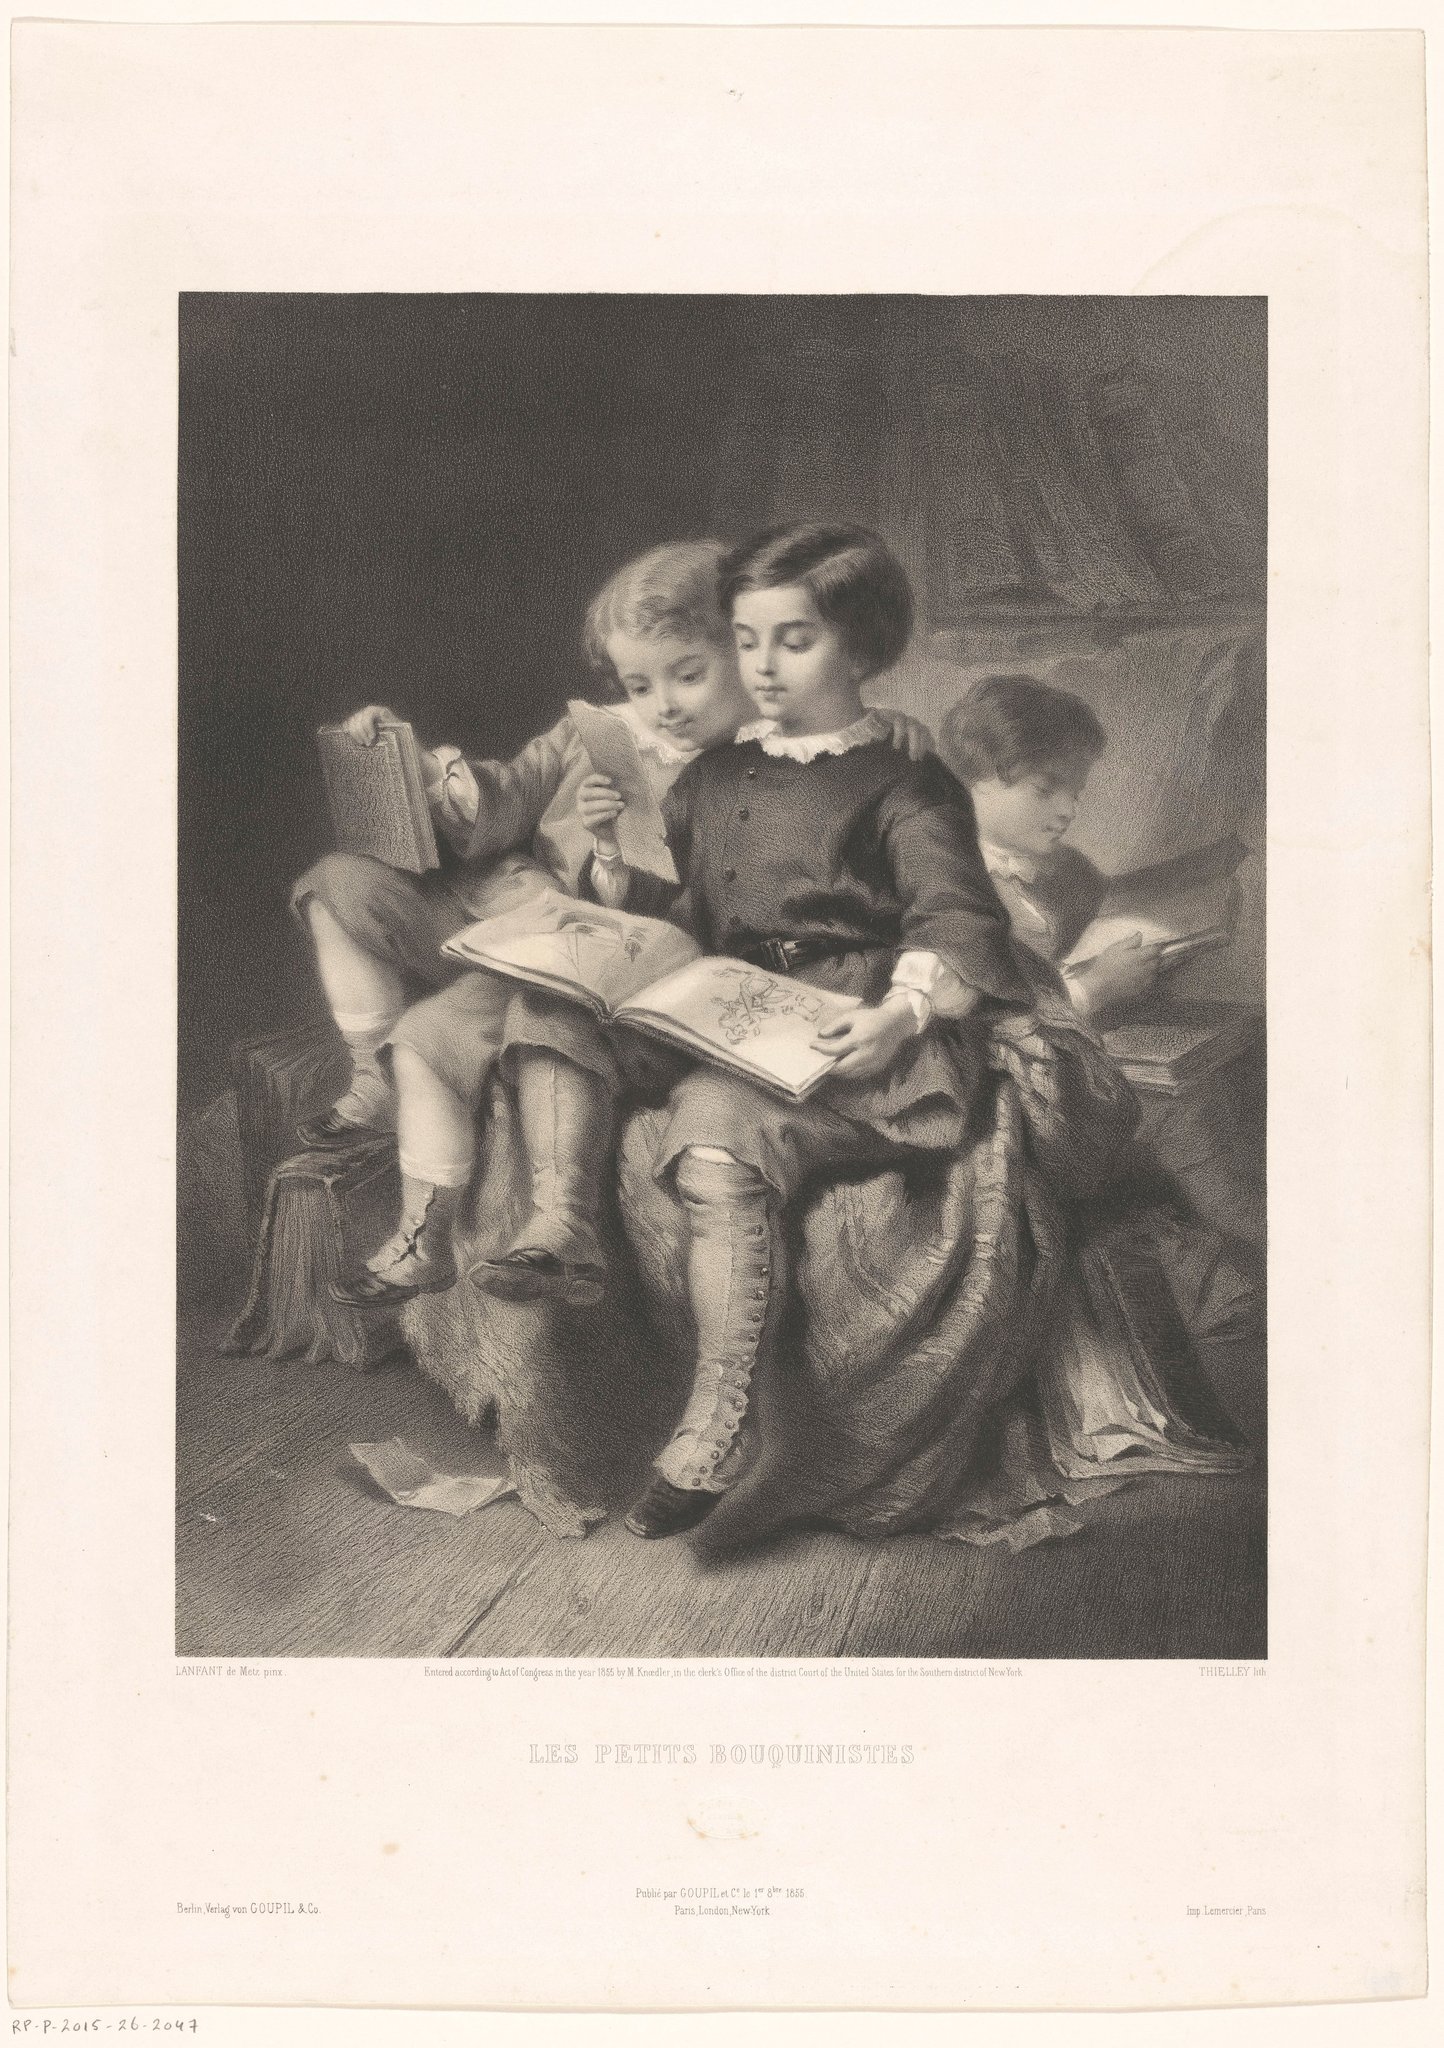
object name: print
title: Les petits bouquinistes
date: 1855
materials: paper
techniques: lithograph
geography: paris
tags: reading, book, book in which illustrations are essential - mm - book open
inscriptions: check stamp: Lugt 1090, collector's mark: Lugt 4780, collector's mark: Lugt 4779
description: De jongen in het midden heeft een opengeslagen album op zijn schoot liggen en houdt in zijn rechterhand een stuk papier. Een andere jongen kijkt over zijn schouder mee terwijl hij een boek in zijn rechterhand houdt. In de achtergrond zit een derde jongen te lezen.